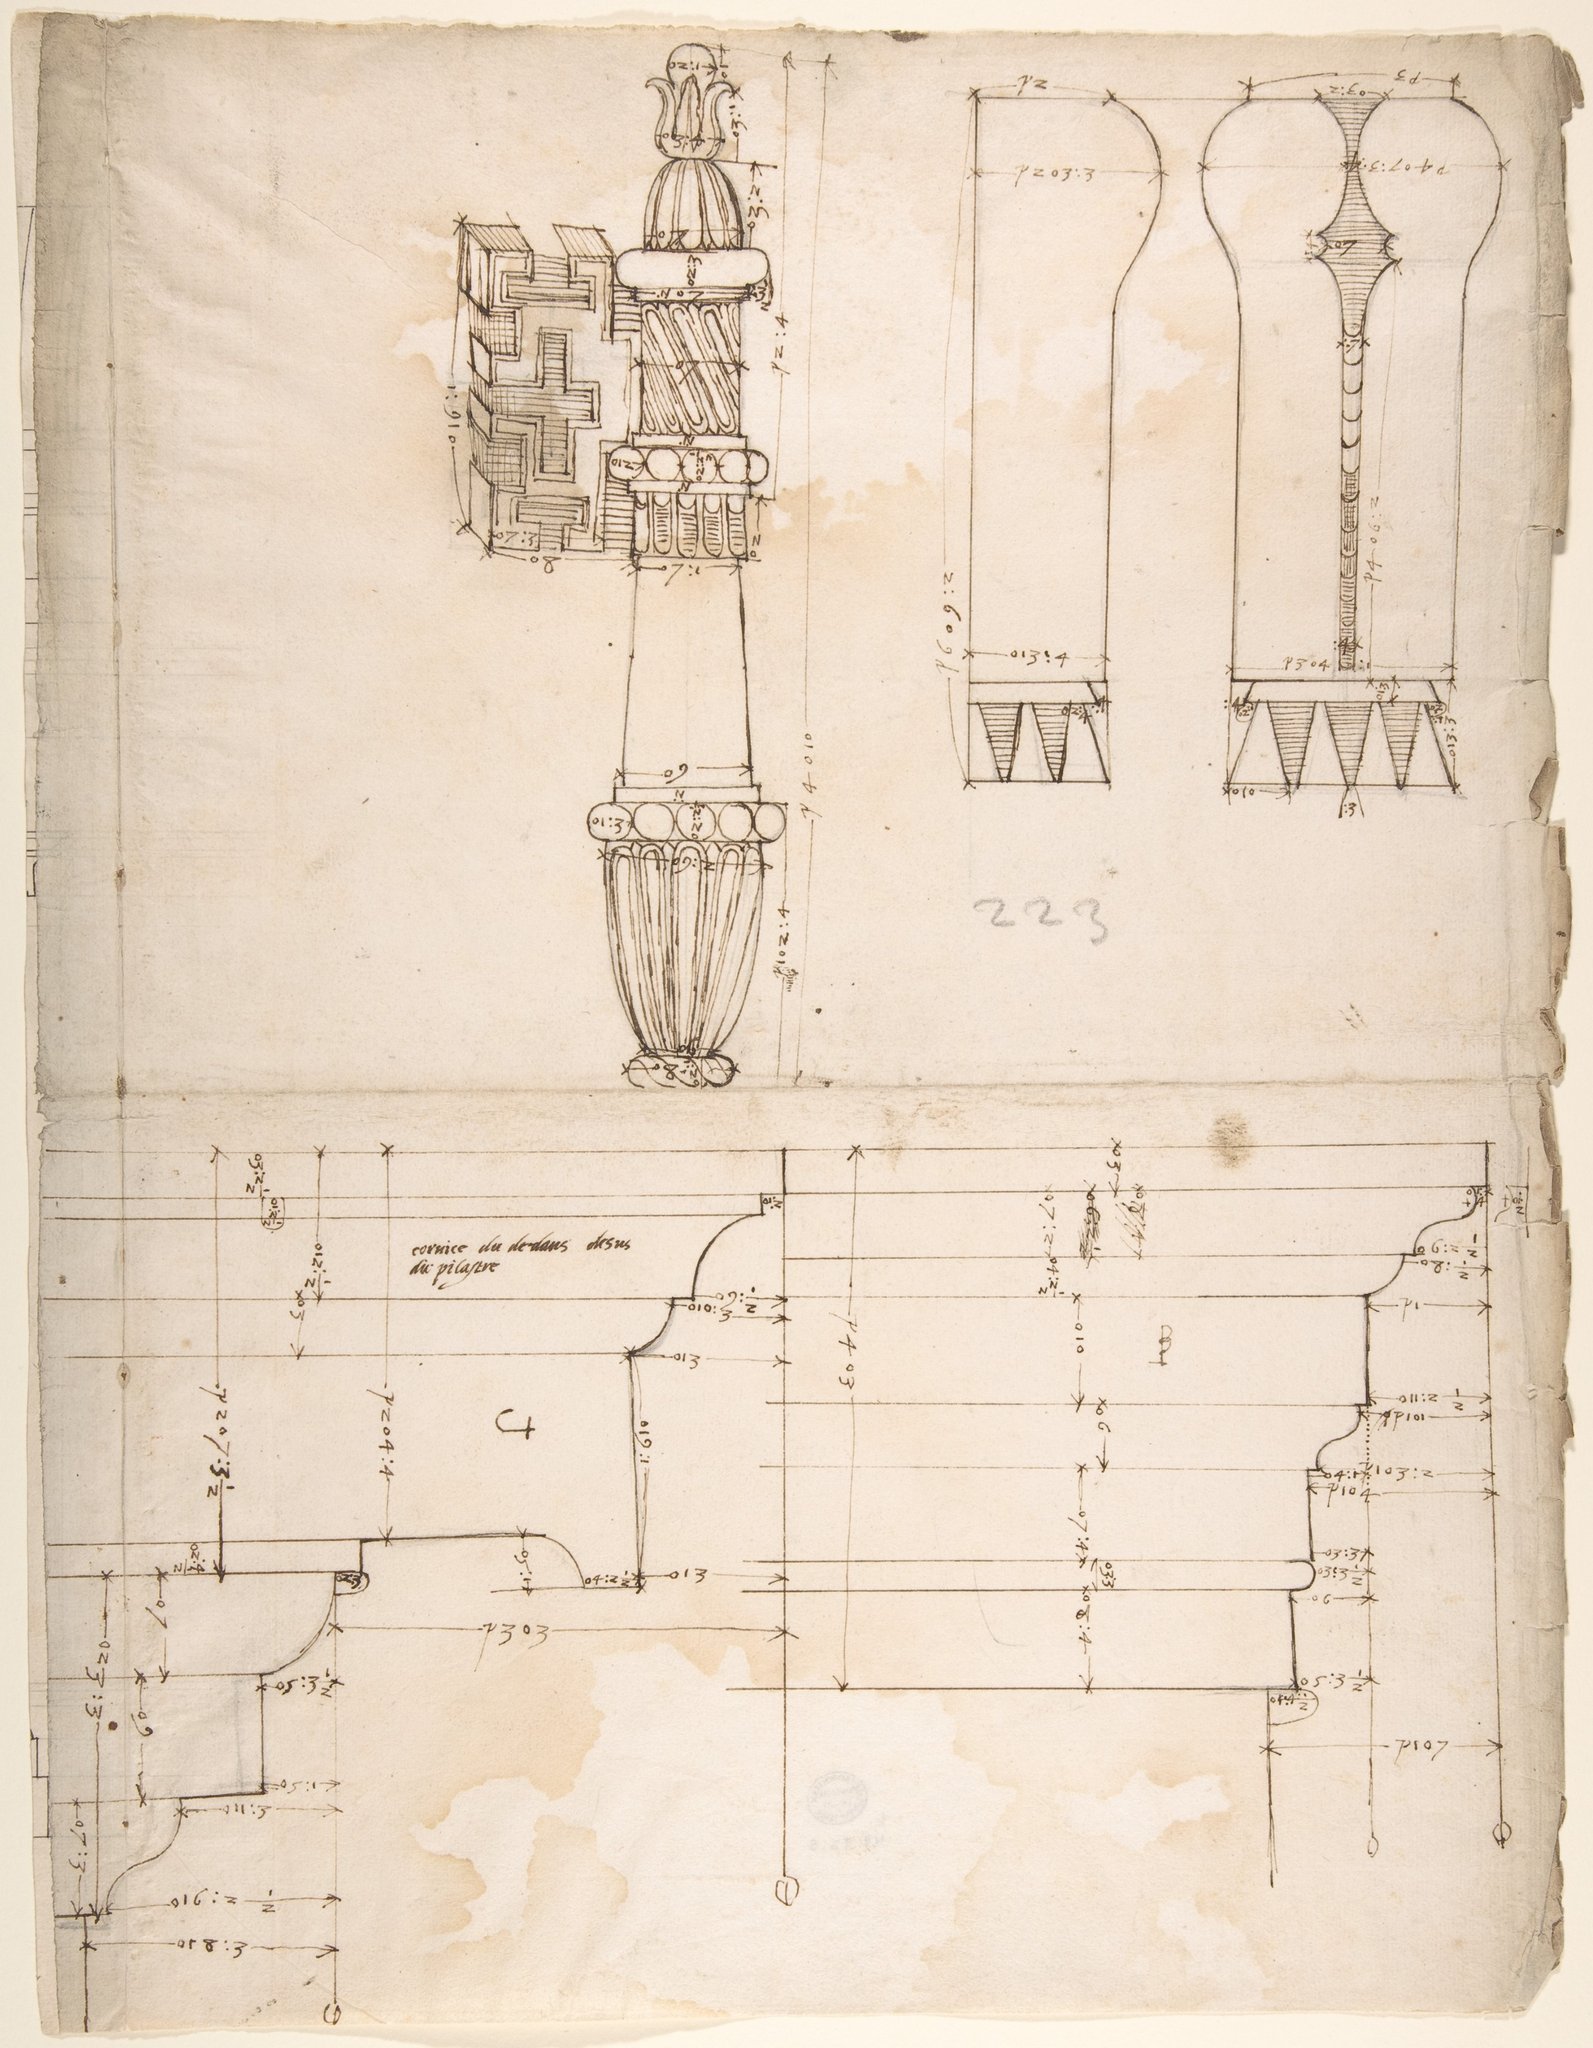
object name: drawing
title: St. Peter's, cornice and architrave, profile; key, elevation; triglyph and guttae, elevation and section (recto) blank (verso)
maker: anonymous, french, 16th century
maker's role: draftsman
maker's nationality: french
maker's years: 1500-1600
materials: chalk, ink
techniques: incising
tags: architecture